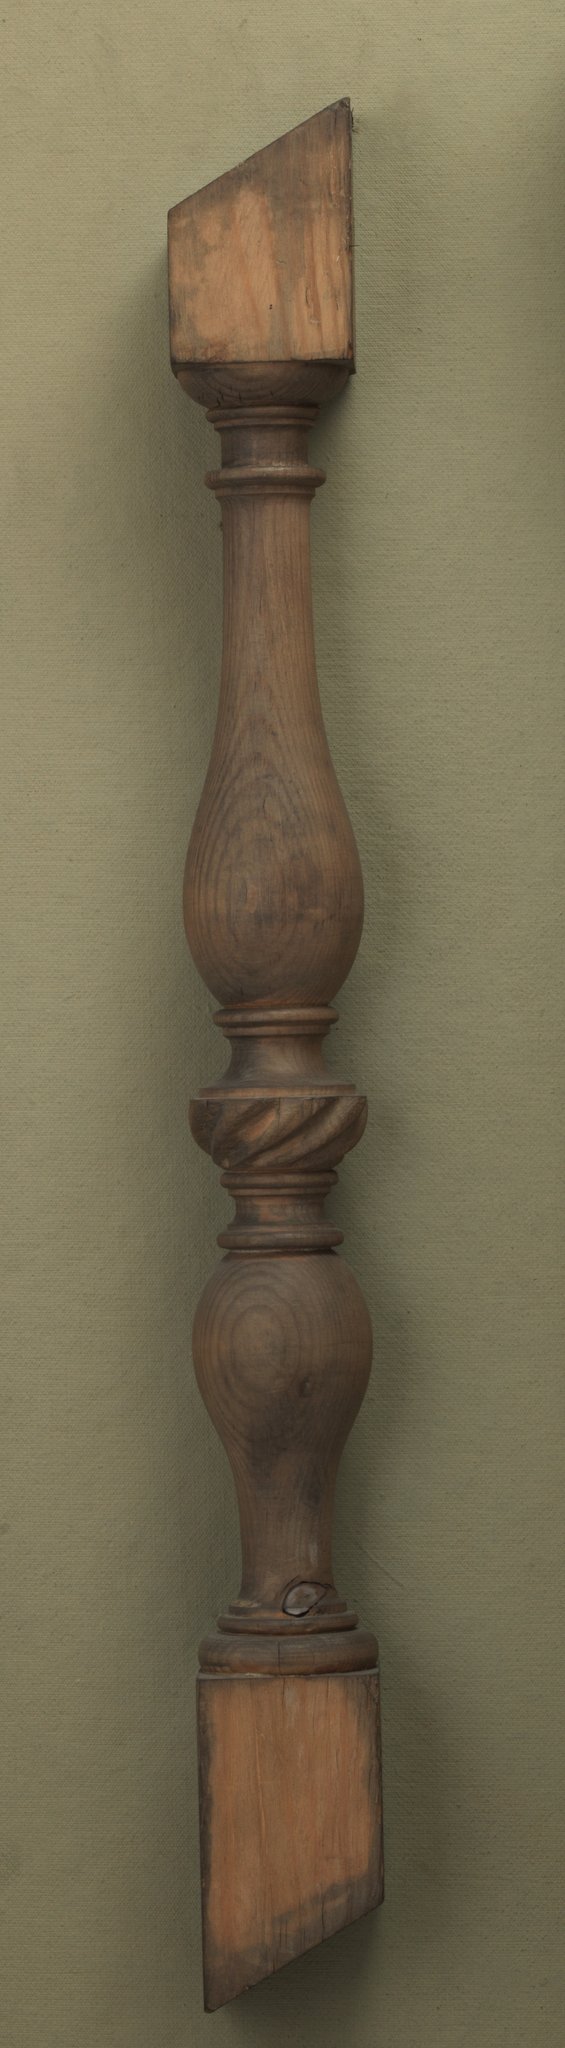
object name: baluster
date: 1701-1750